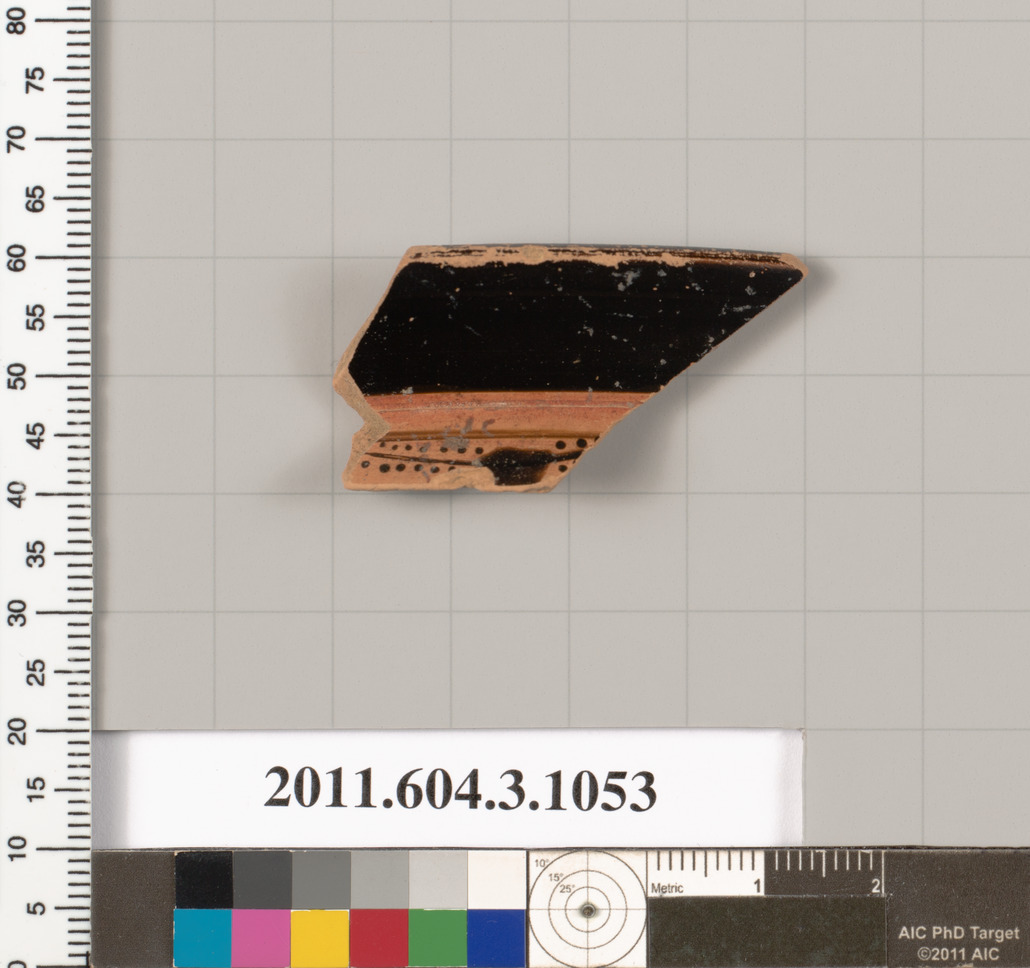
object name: mastoid fragment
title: Terracotta fragment of a mastoid (drinking cup with narrow base)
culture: greek, attic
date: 534-468 BCE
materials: terracotta